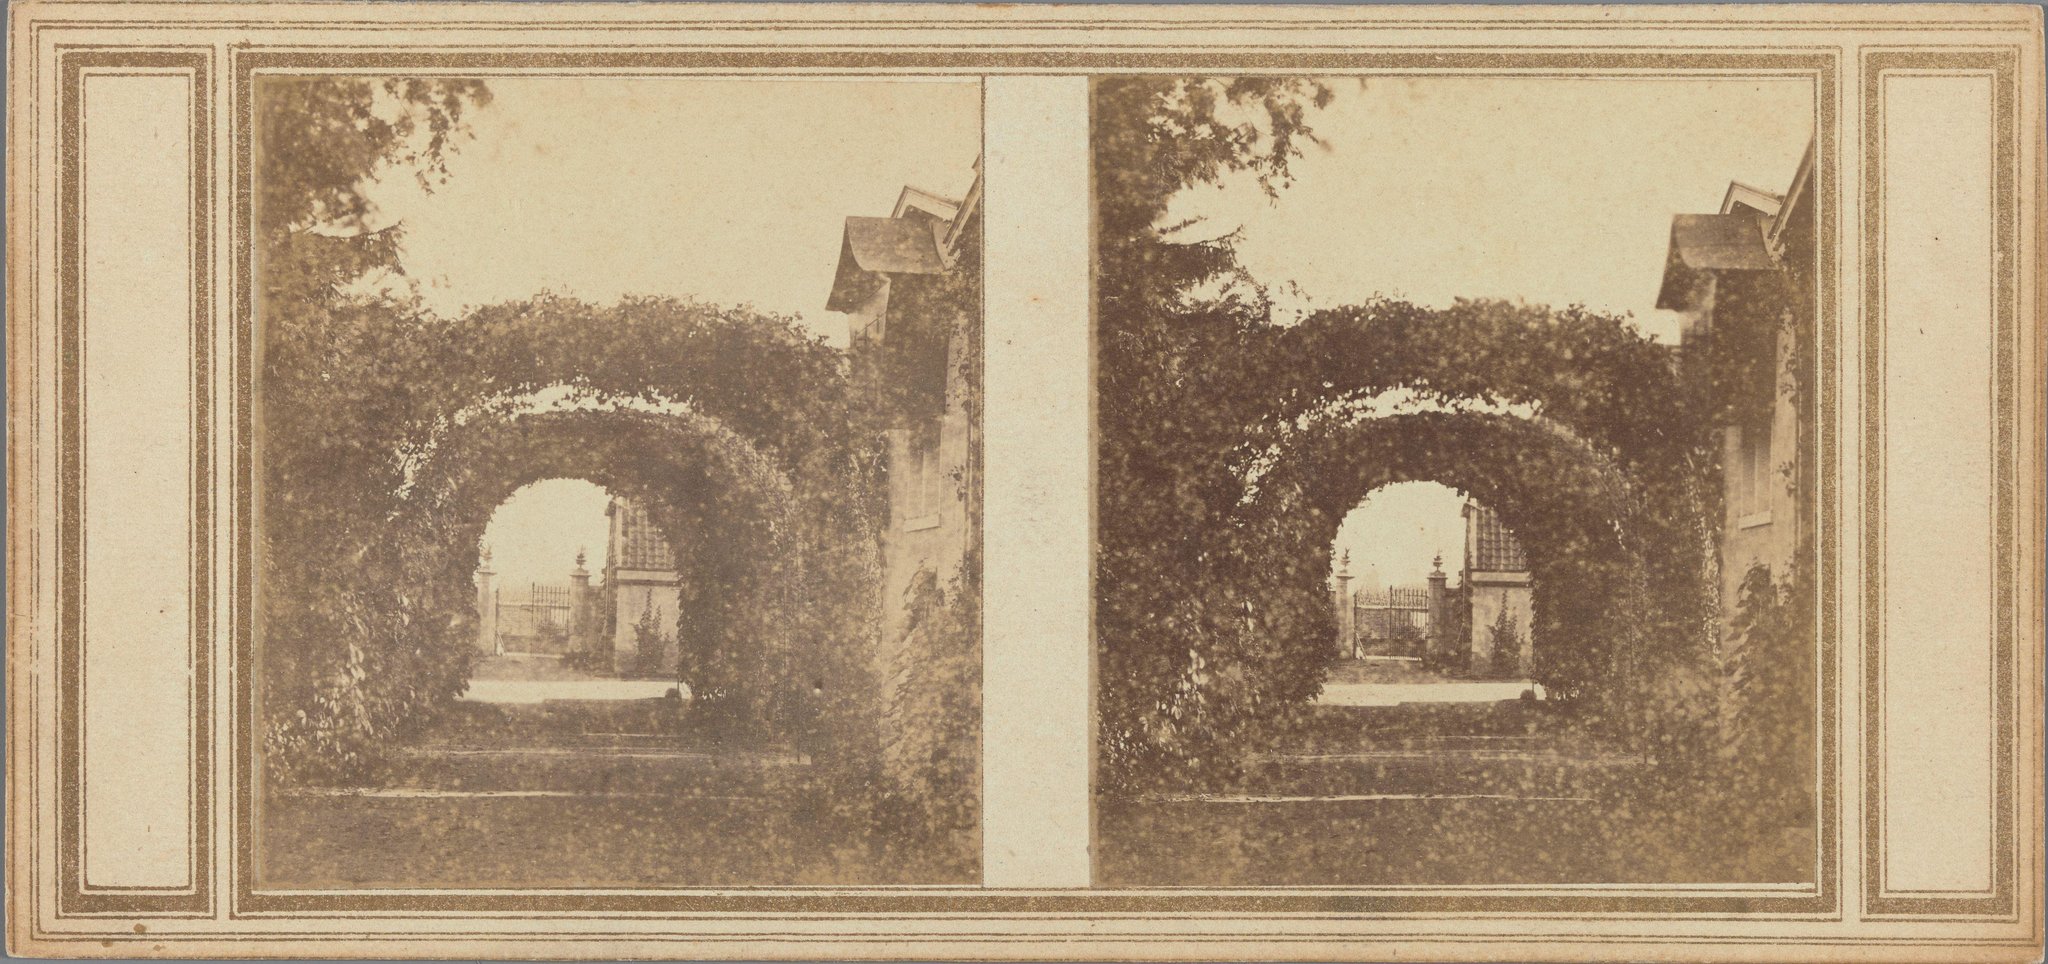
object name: stereograph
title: Loofgang (berceau) met aan het einde een hek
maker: Anonymous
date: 1860-1880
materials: cardboard, paper, photographic support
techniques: albumen print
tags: garden, gate, entrance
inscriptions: inscription: ‘Door de Waranda naar de Moestuin.’